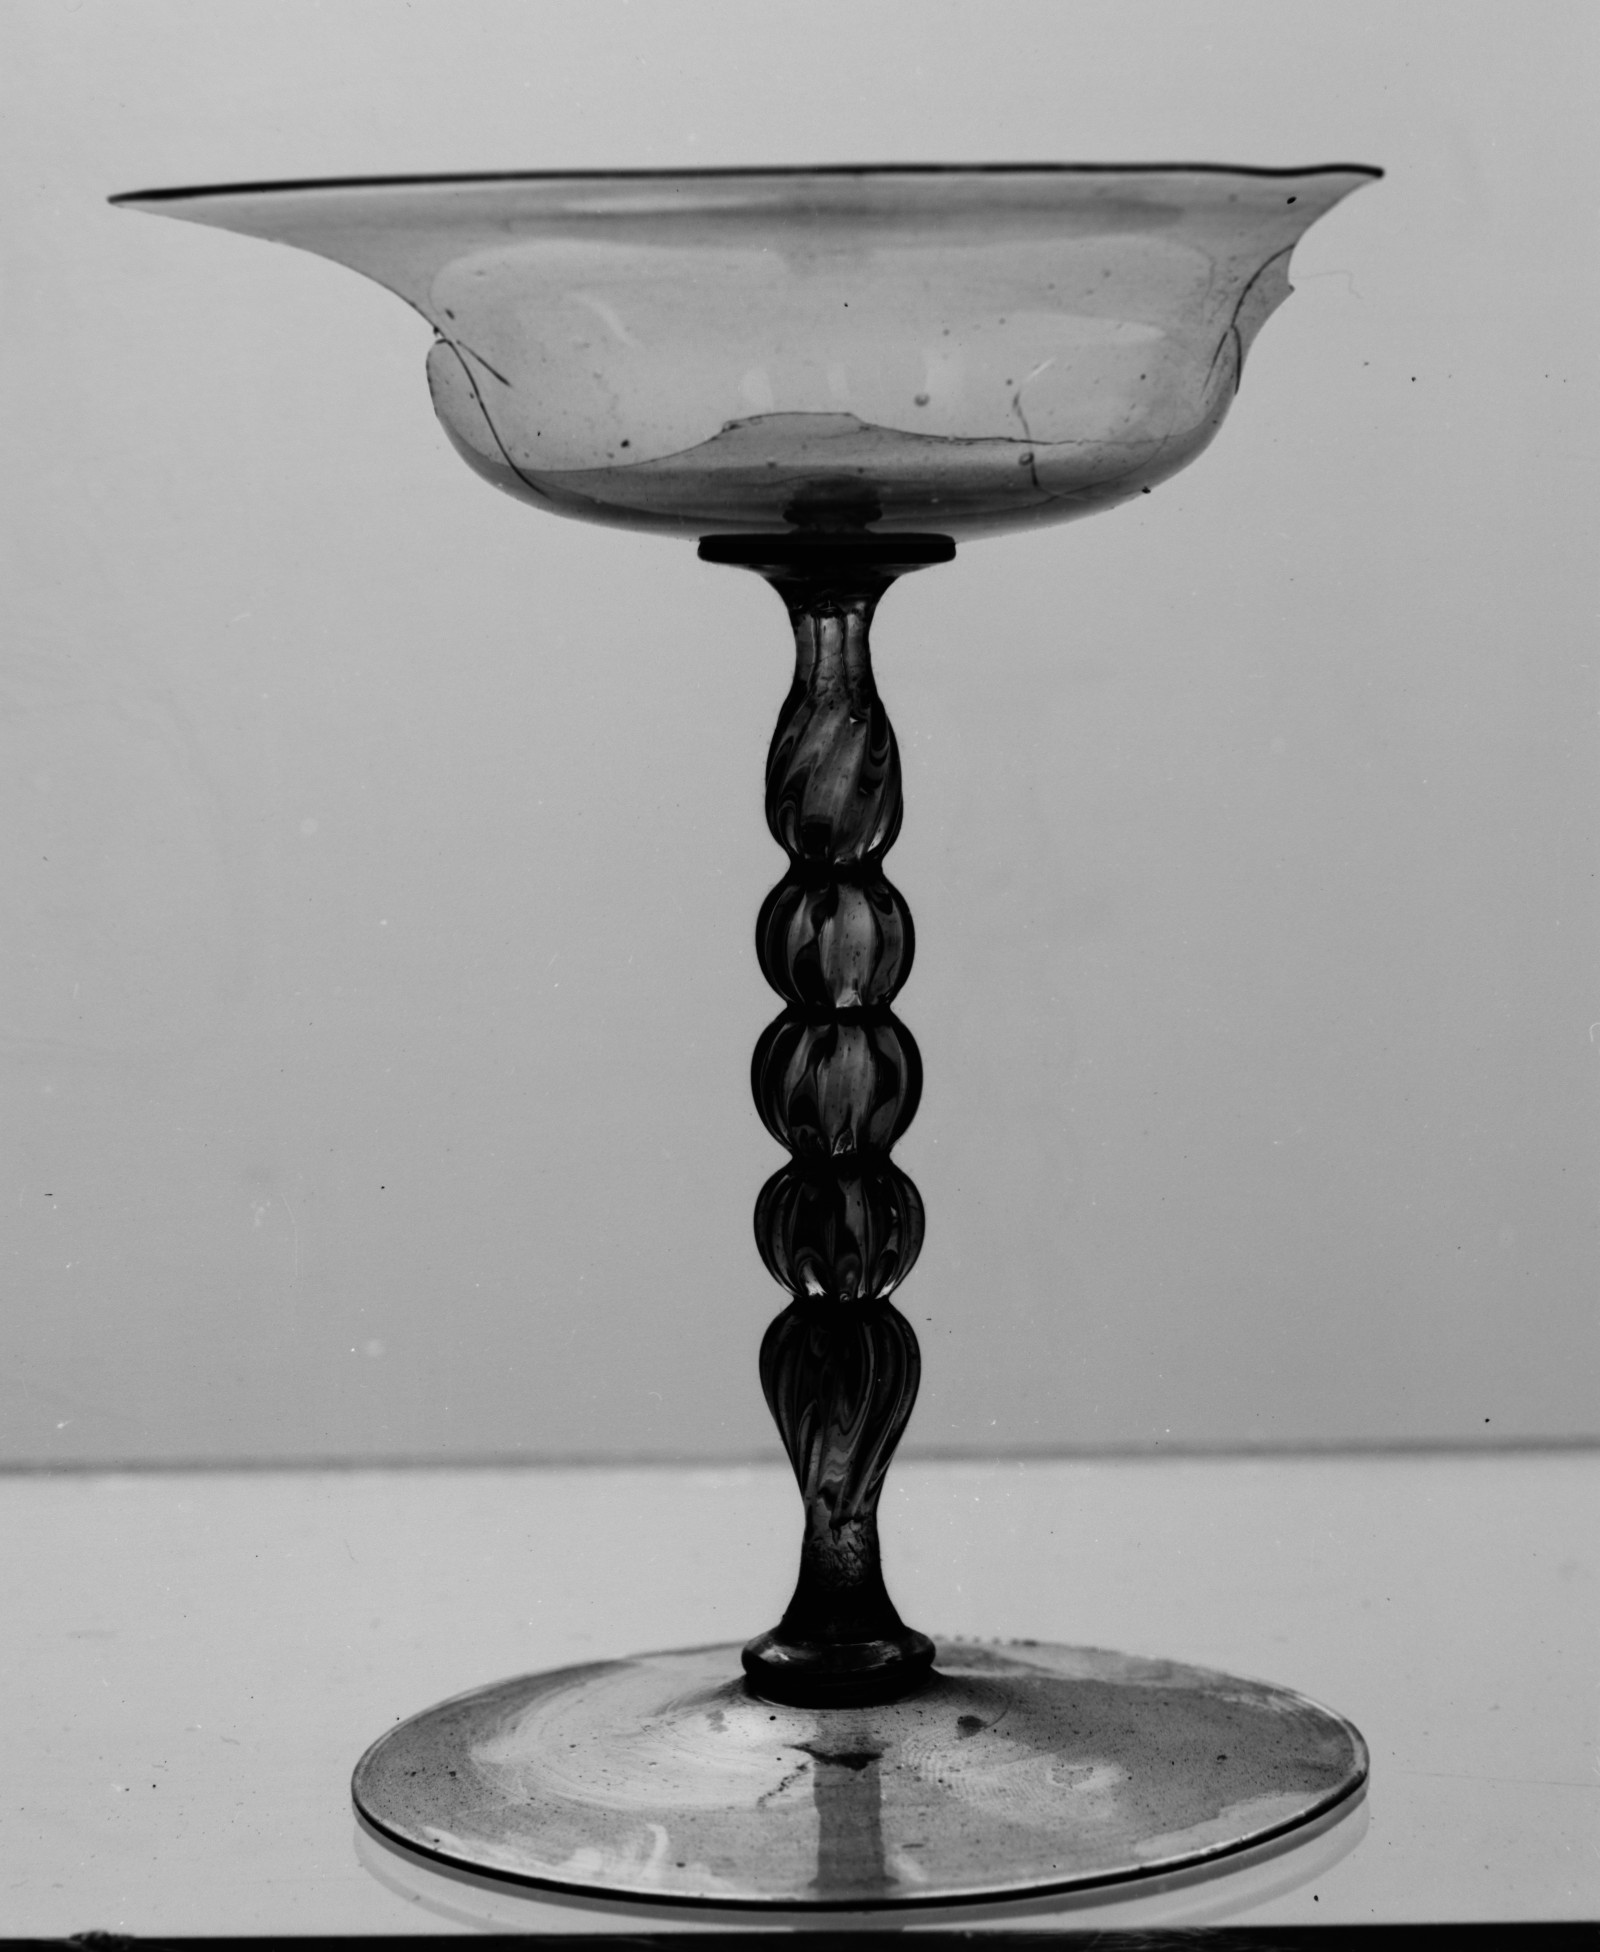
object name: wineglass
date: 1601-1700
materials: glass